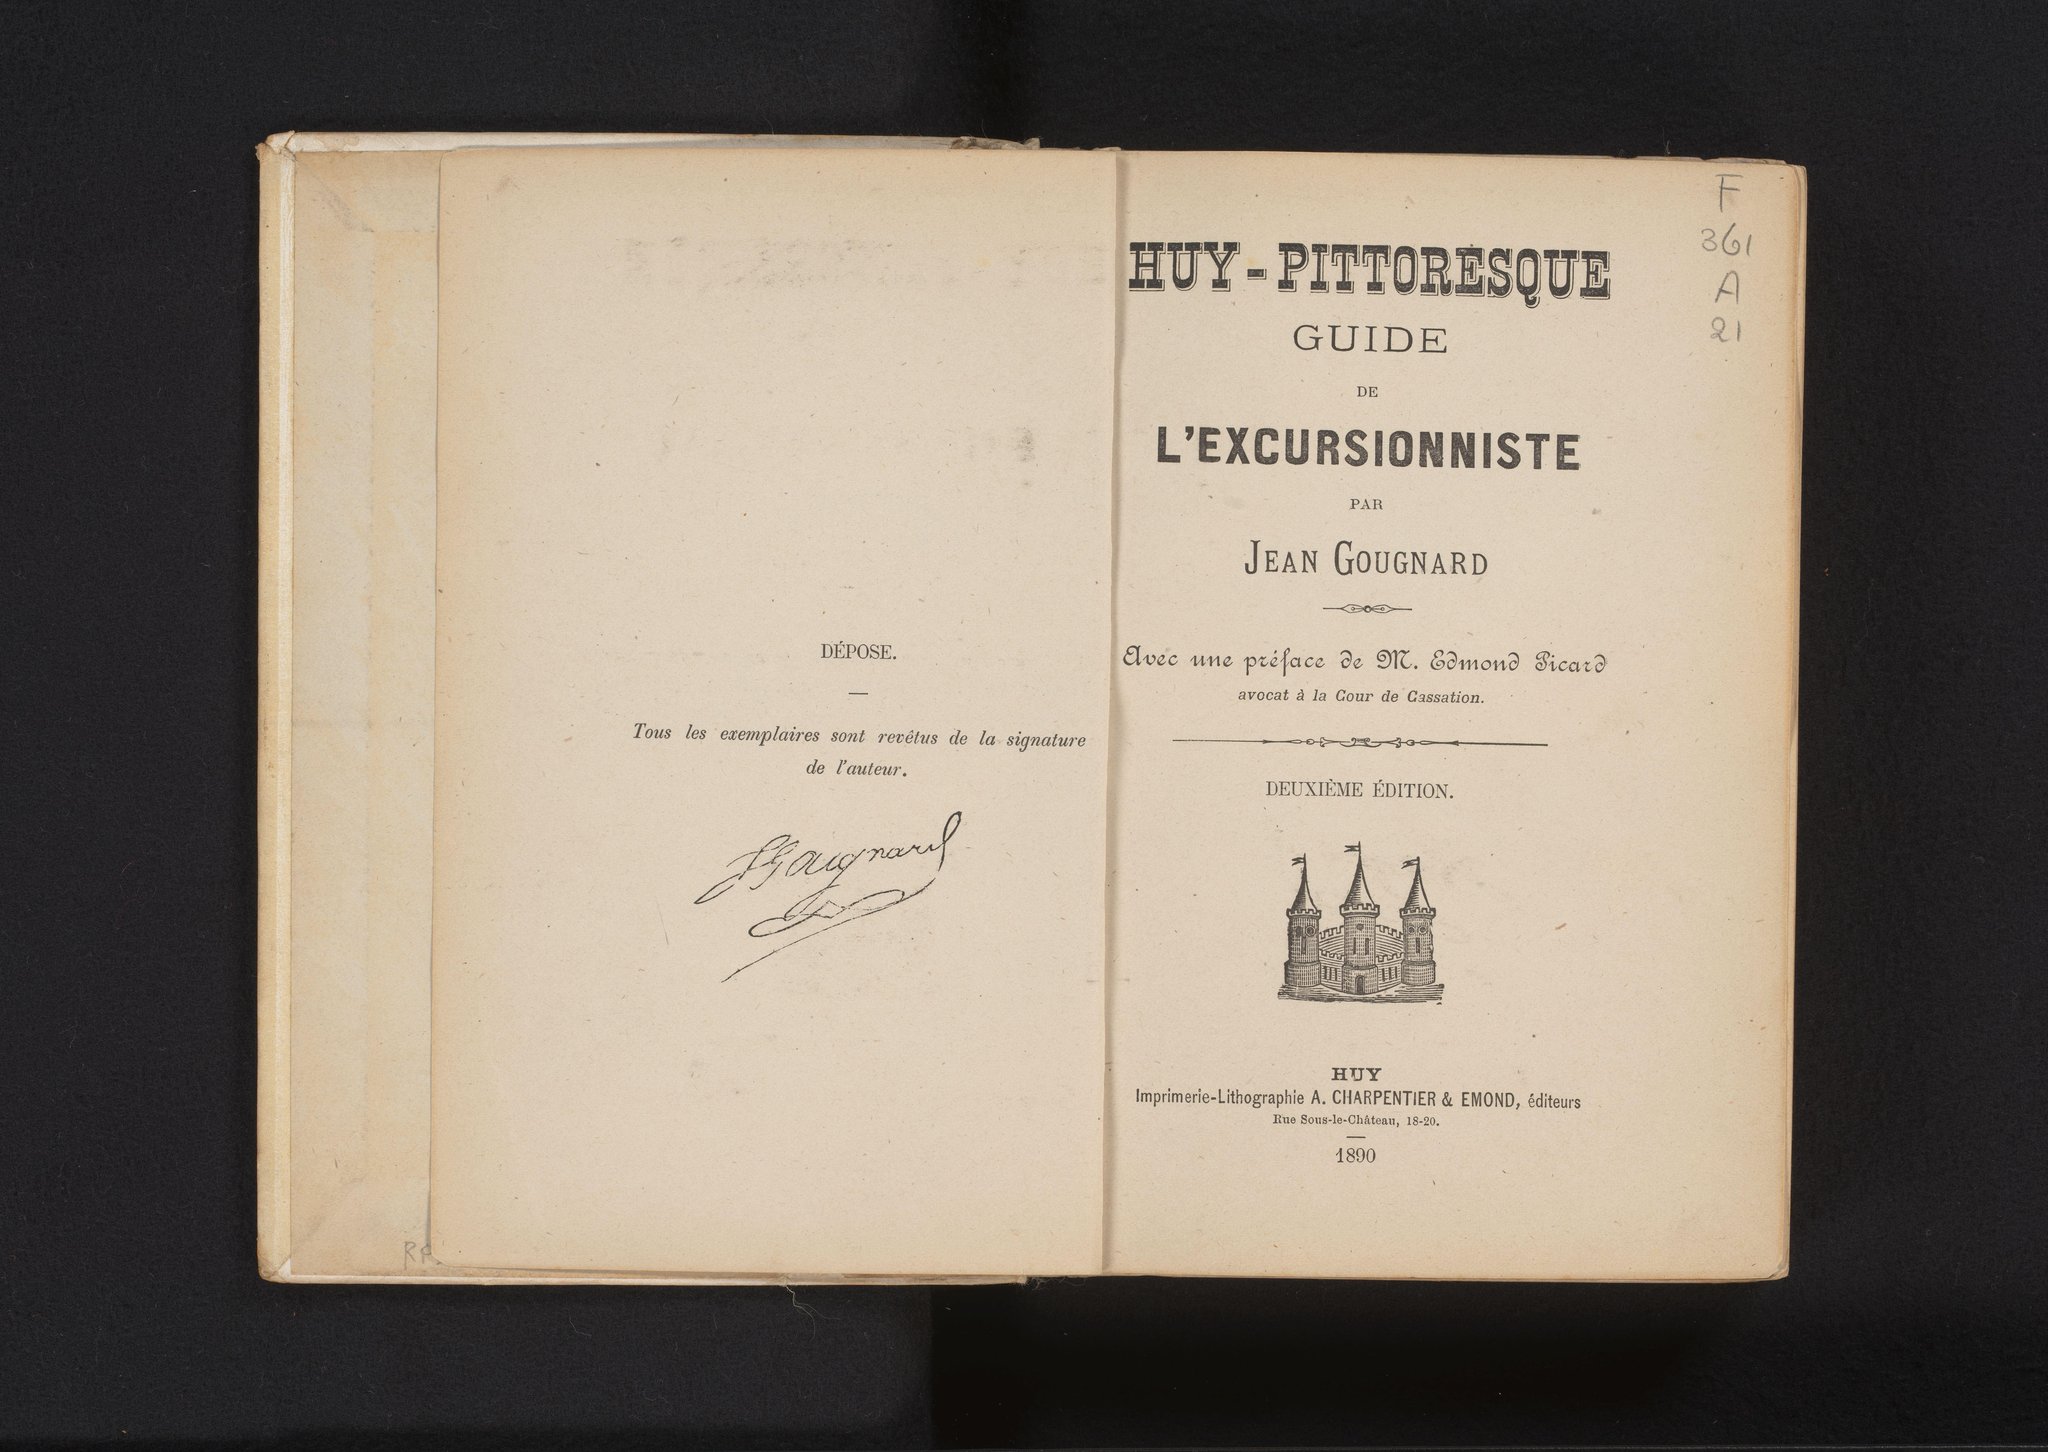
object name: book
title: Huy-pittoresque : guide de l'excursionniste / par Jean Gougnard; avec une préface de Edmond Picard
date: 1890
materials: cardboard, linen, paper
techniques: photograph, printing, engraving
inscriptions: annotation: ‘MAY/ 2005’